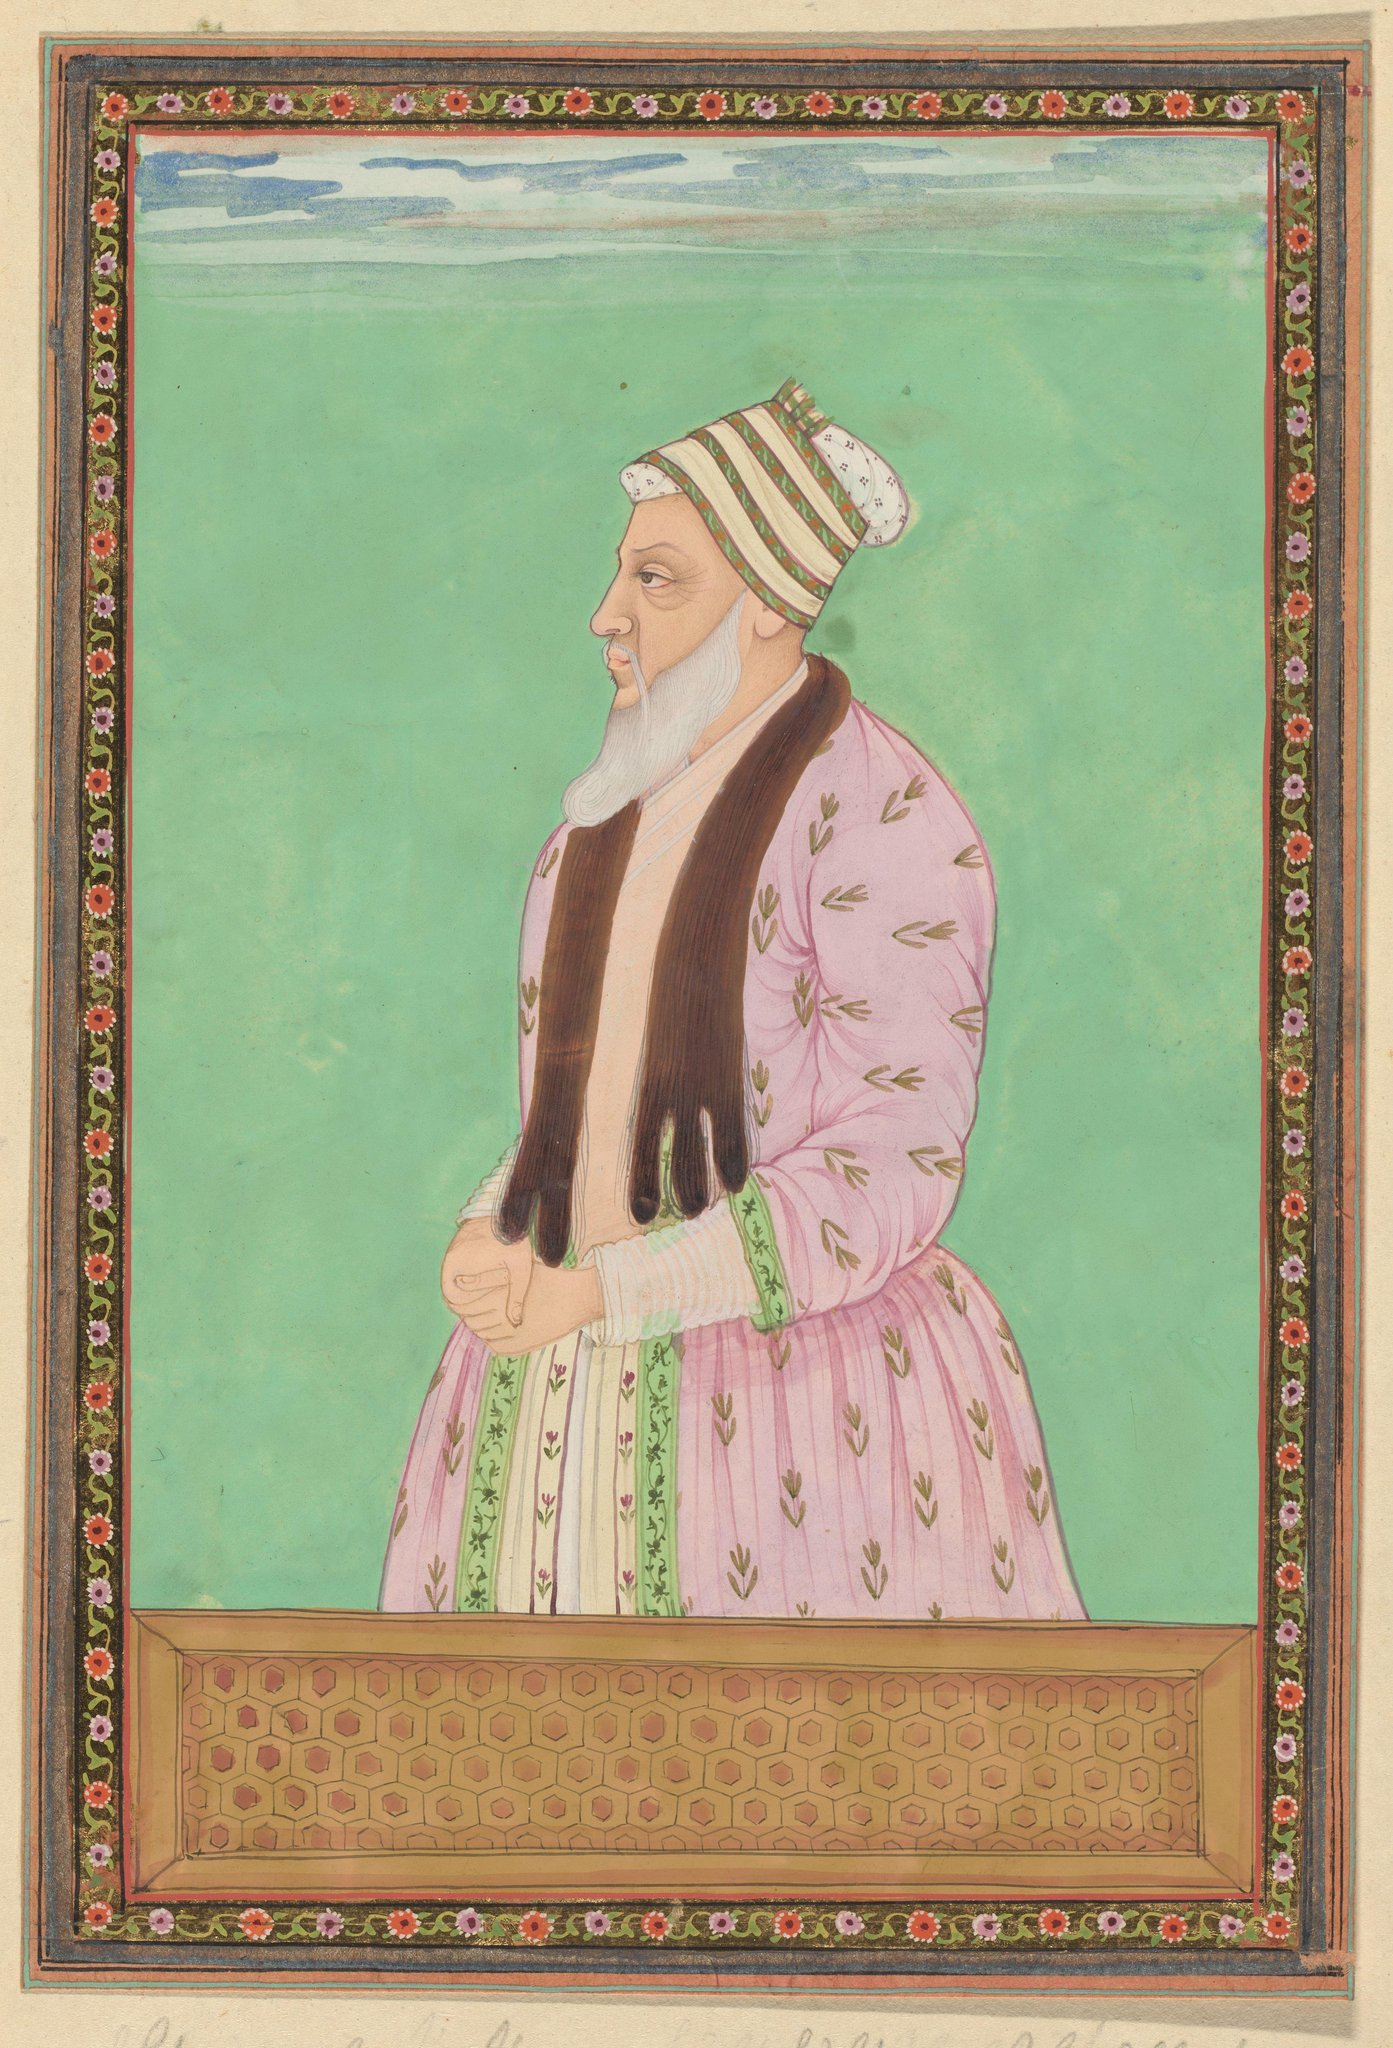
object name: indian miniature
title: Portret van Sharza Khan, die in de tijd van Sultan Abdullah als vizier heeft gediend en ook vizier is in de tijd van Abul Hasan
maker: Anonymous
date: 1686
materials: paint, gold leaf, gouache, paper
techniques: brush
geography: golkonda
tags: amsterdam, mayor, nicolaes cornelisz. witsen, historical person (...) - historical person (...) portrayed alone, ruler, sovereign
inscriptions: collector's mark: Lugt 1838, collector's mark: Lugt 240, annotation: ‘Stersechan Visir van de Sultans Abdullah en Abulhasan’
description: Sharza Khan is tot aan zijn heupen afgebeeld, naar links gewend, met zijn handen gevouwen voor zich. Blad 35 in het `Witsen-Album', met 49 Indiase miniaturen van vorsten. Boven het portret een stukje papier met de naam in het Perzisch. Onder het portret een stukje papier met de naam in het Portugees.